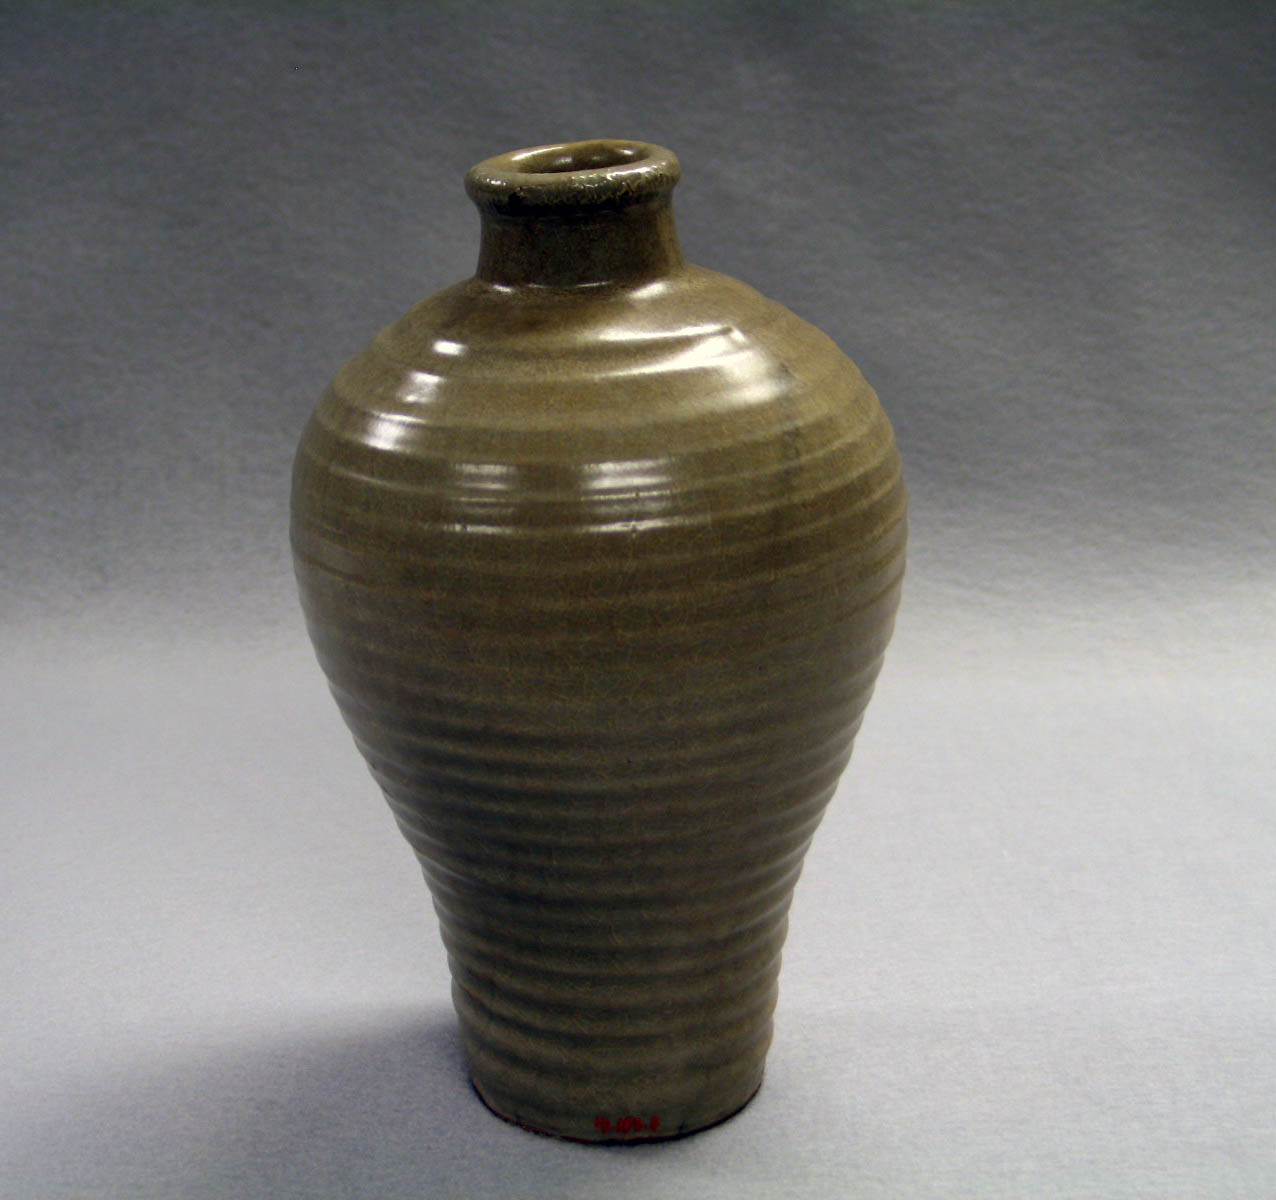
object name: vase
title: Meiping vase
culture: chinese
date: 1201-1300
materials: ceramic glaze, glaze, stoneware